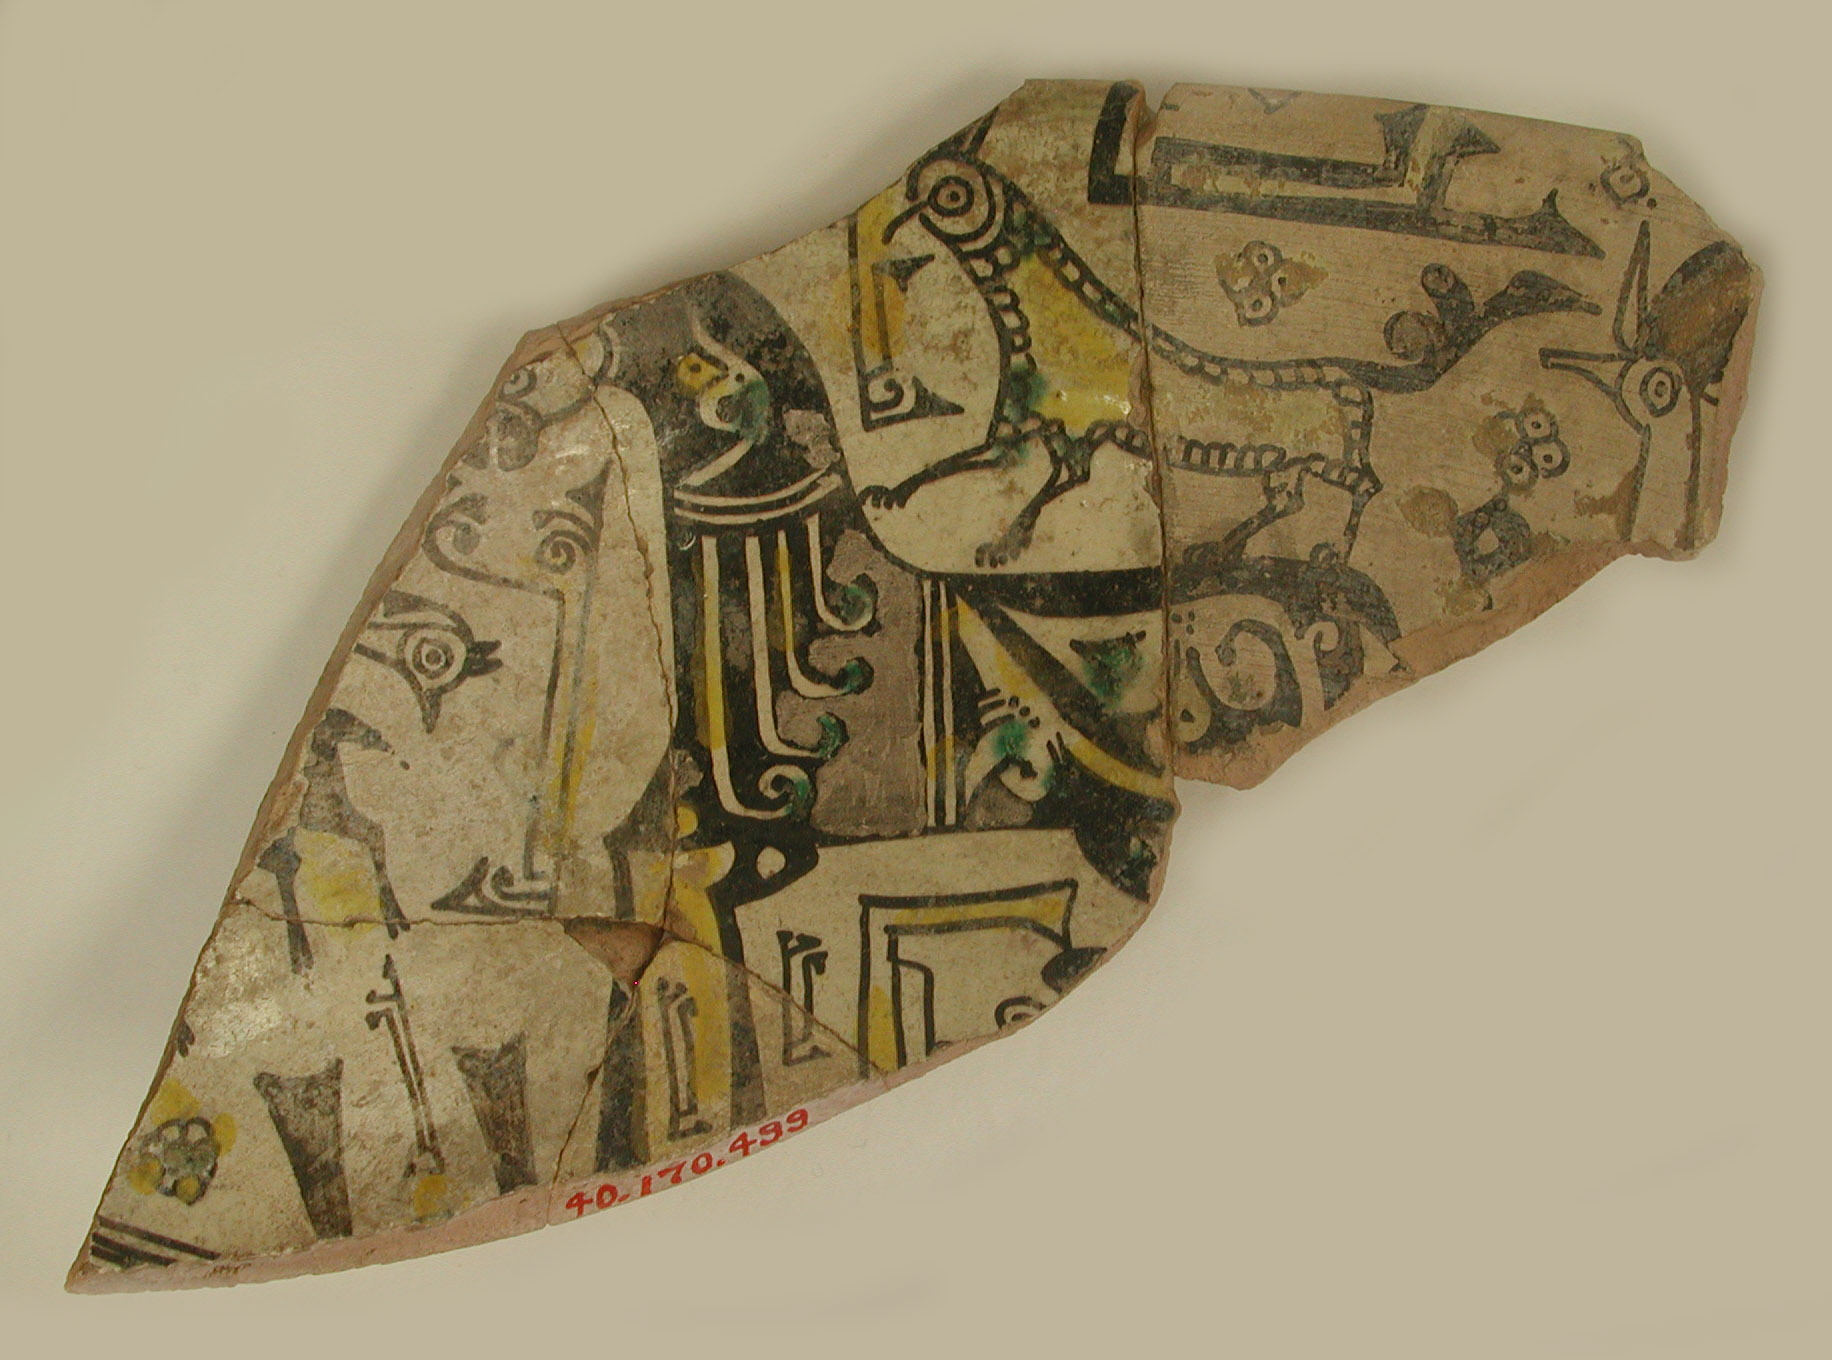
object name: fragment of a bowl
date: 801-1000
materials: earthenware, glaze, pigment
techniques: painting, polychrome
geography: iran